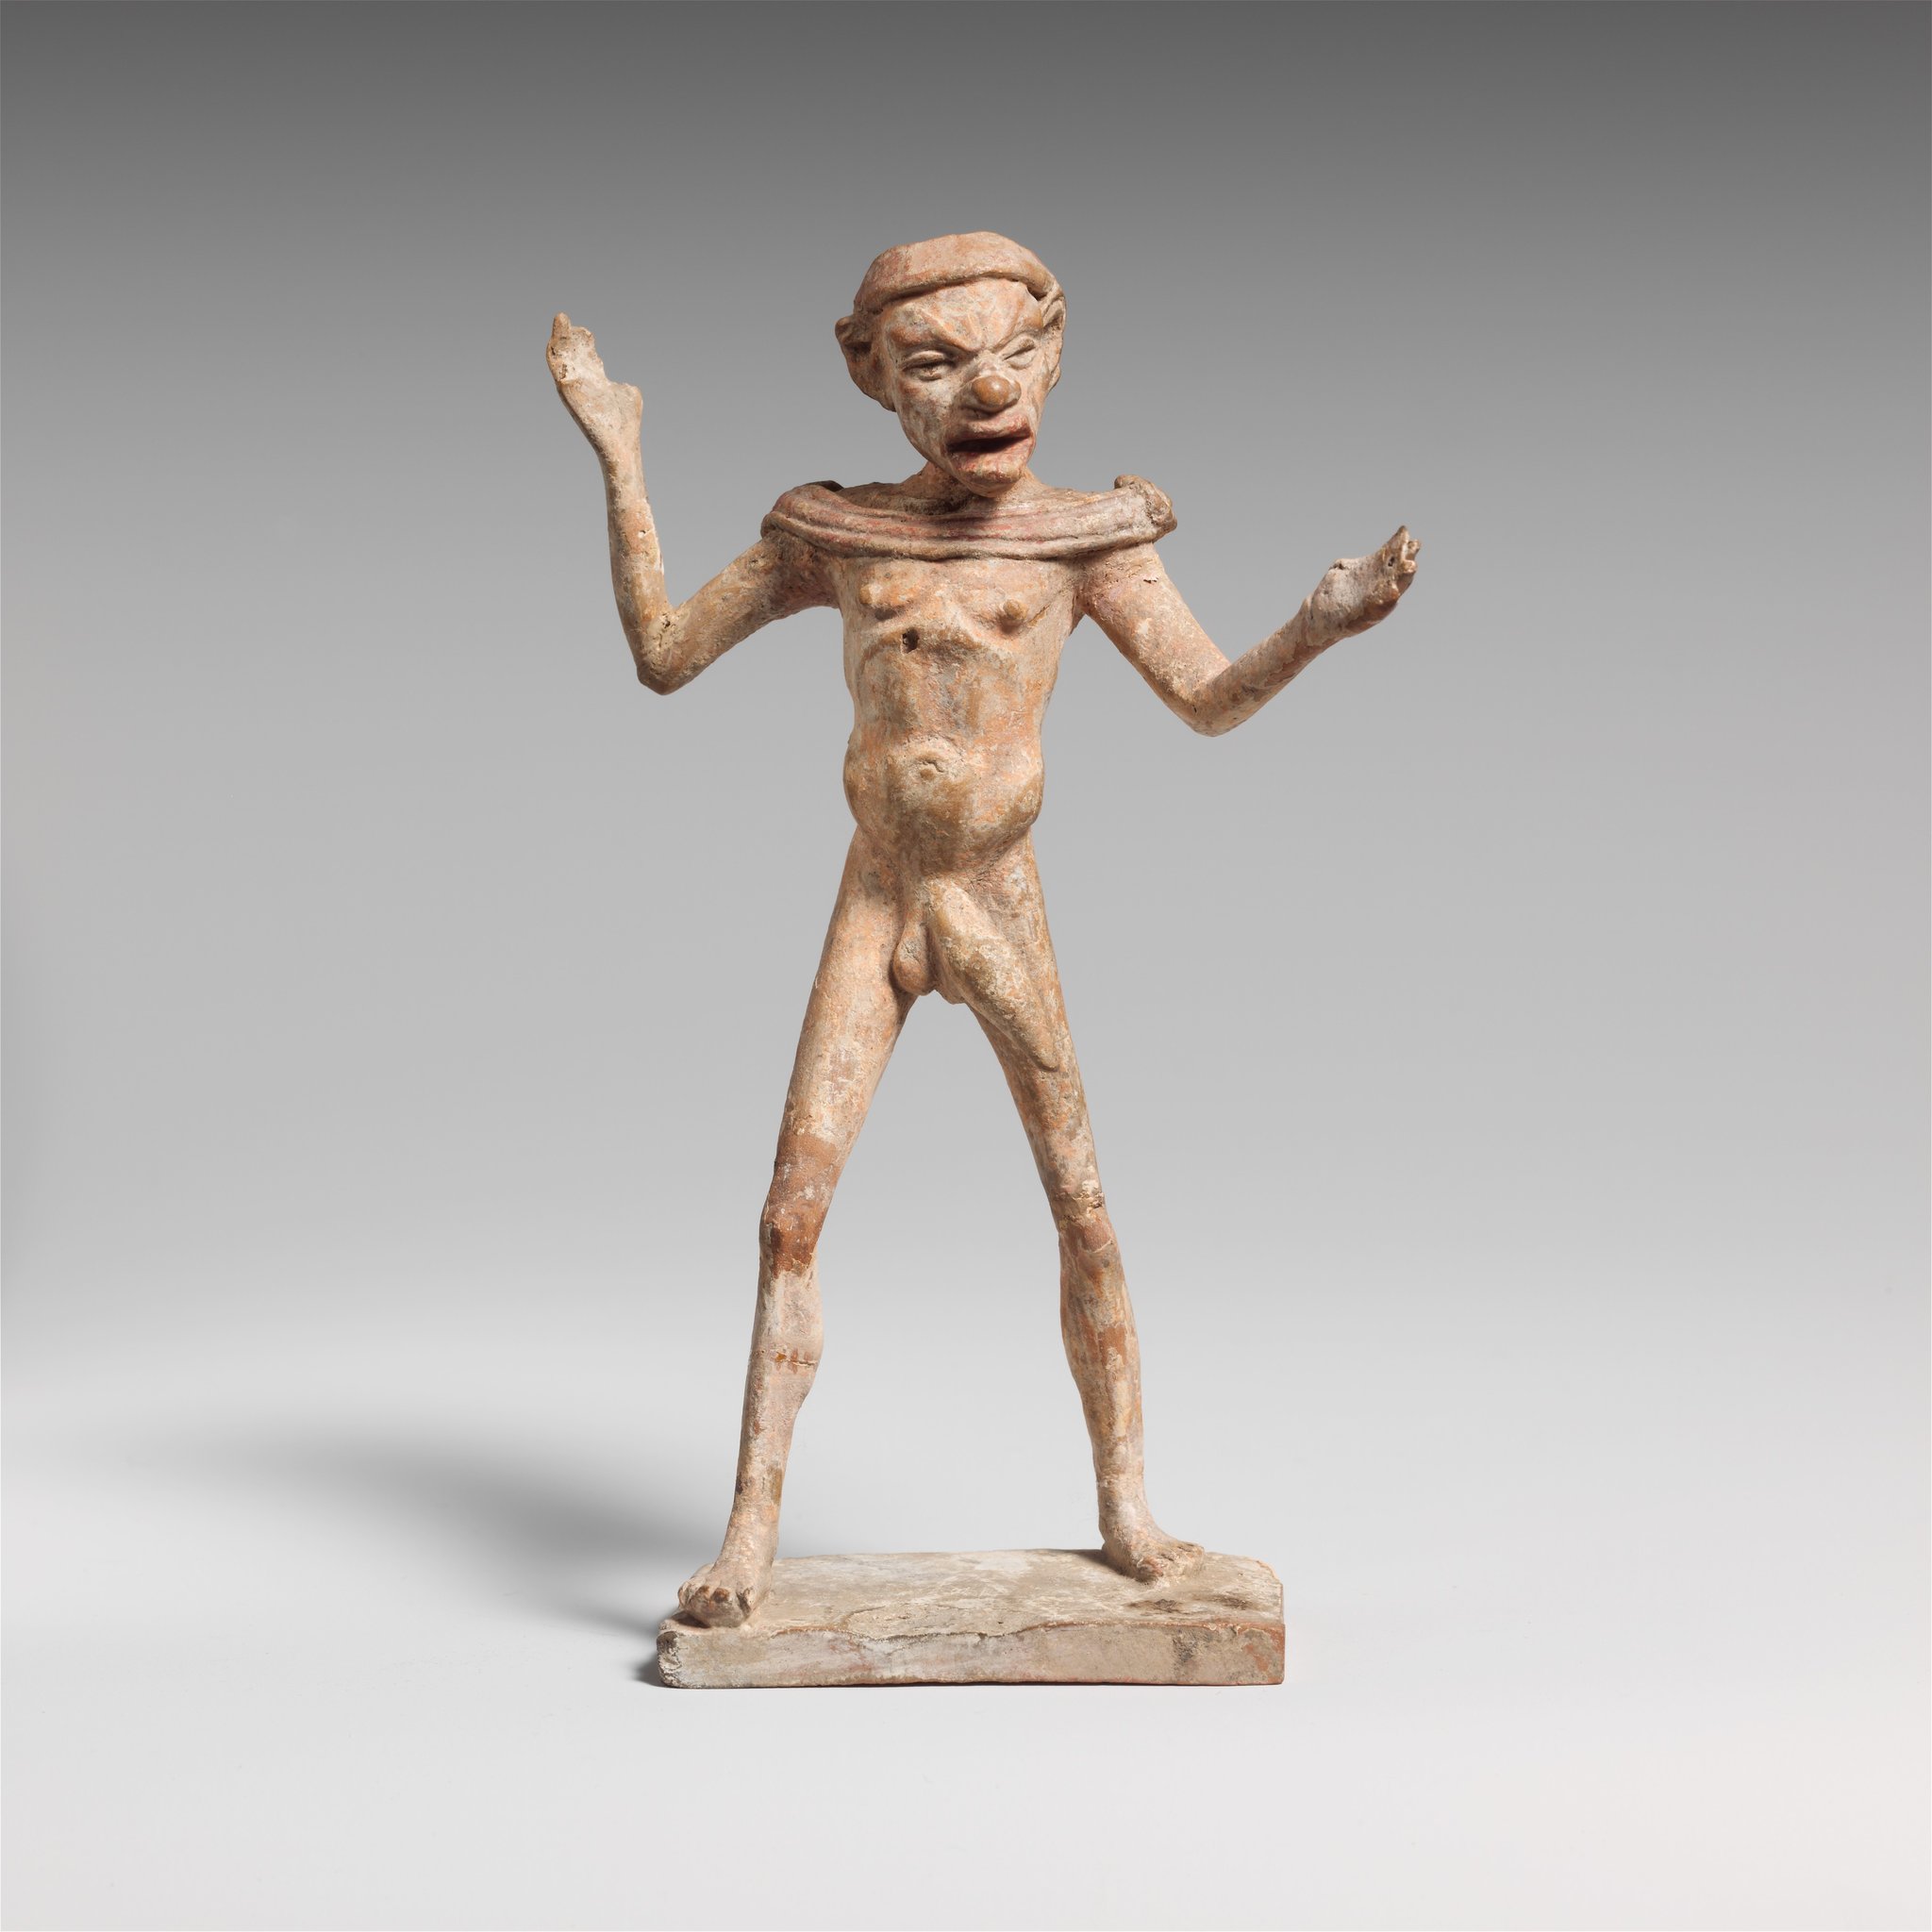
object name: statuette of a man, grotesque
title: Terracotta statuette of a man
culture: greek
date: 200-1 BCE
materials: terracotta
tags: male nudes